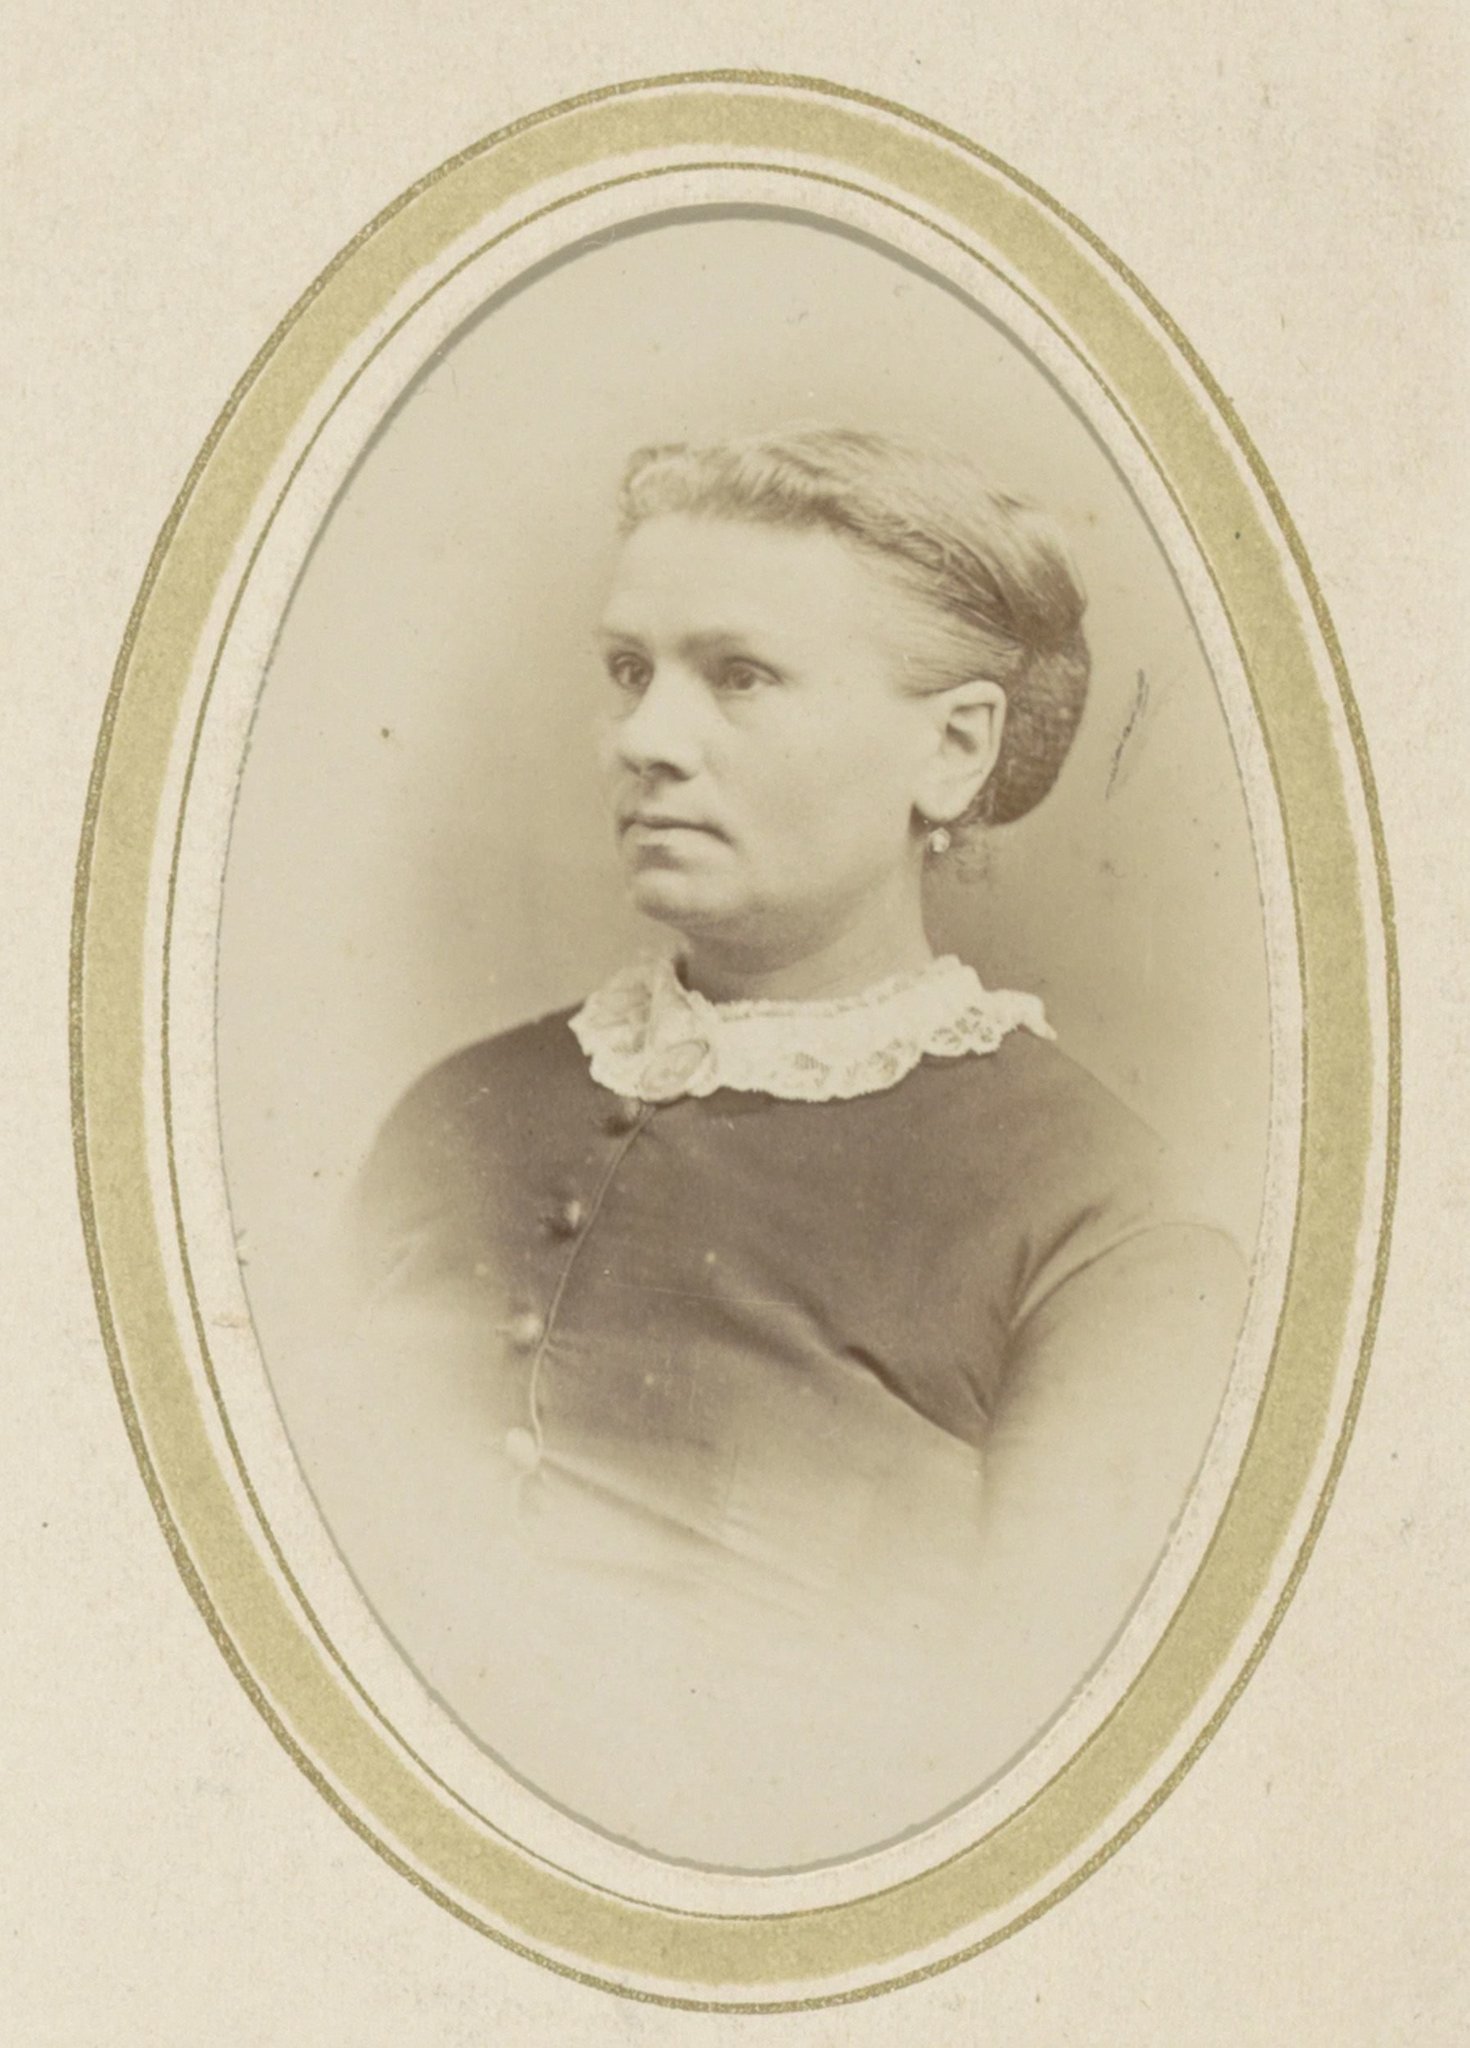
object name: photograph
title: Portret van een vrouw met een kanten kraag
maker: abraham koorenhoff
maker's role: fotograaf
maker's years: 1844-1917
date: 1863-1900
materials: cardboard, paper, photographic support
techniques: albumen print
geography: leiden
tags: historical persons, styles of hairdress - aa - ~ women, neck-gear ~ clothing, clothing for the upper part of the body, leiden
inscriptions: address: ‘Leiden’, address: ‘Leiden Muskadelsteeg No. 5 by de Pieterskerk’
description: Onderdeel van Fotoalbum van een Nederlandse familie met 168 cartes-de-visite en kabinetfoto's.